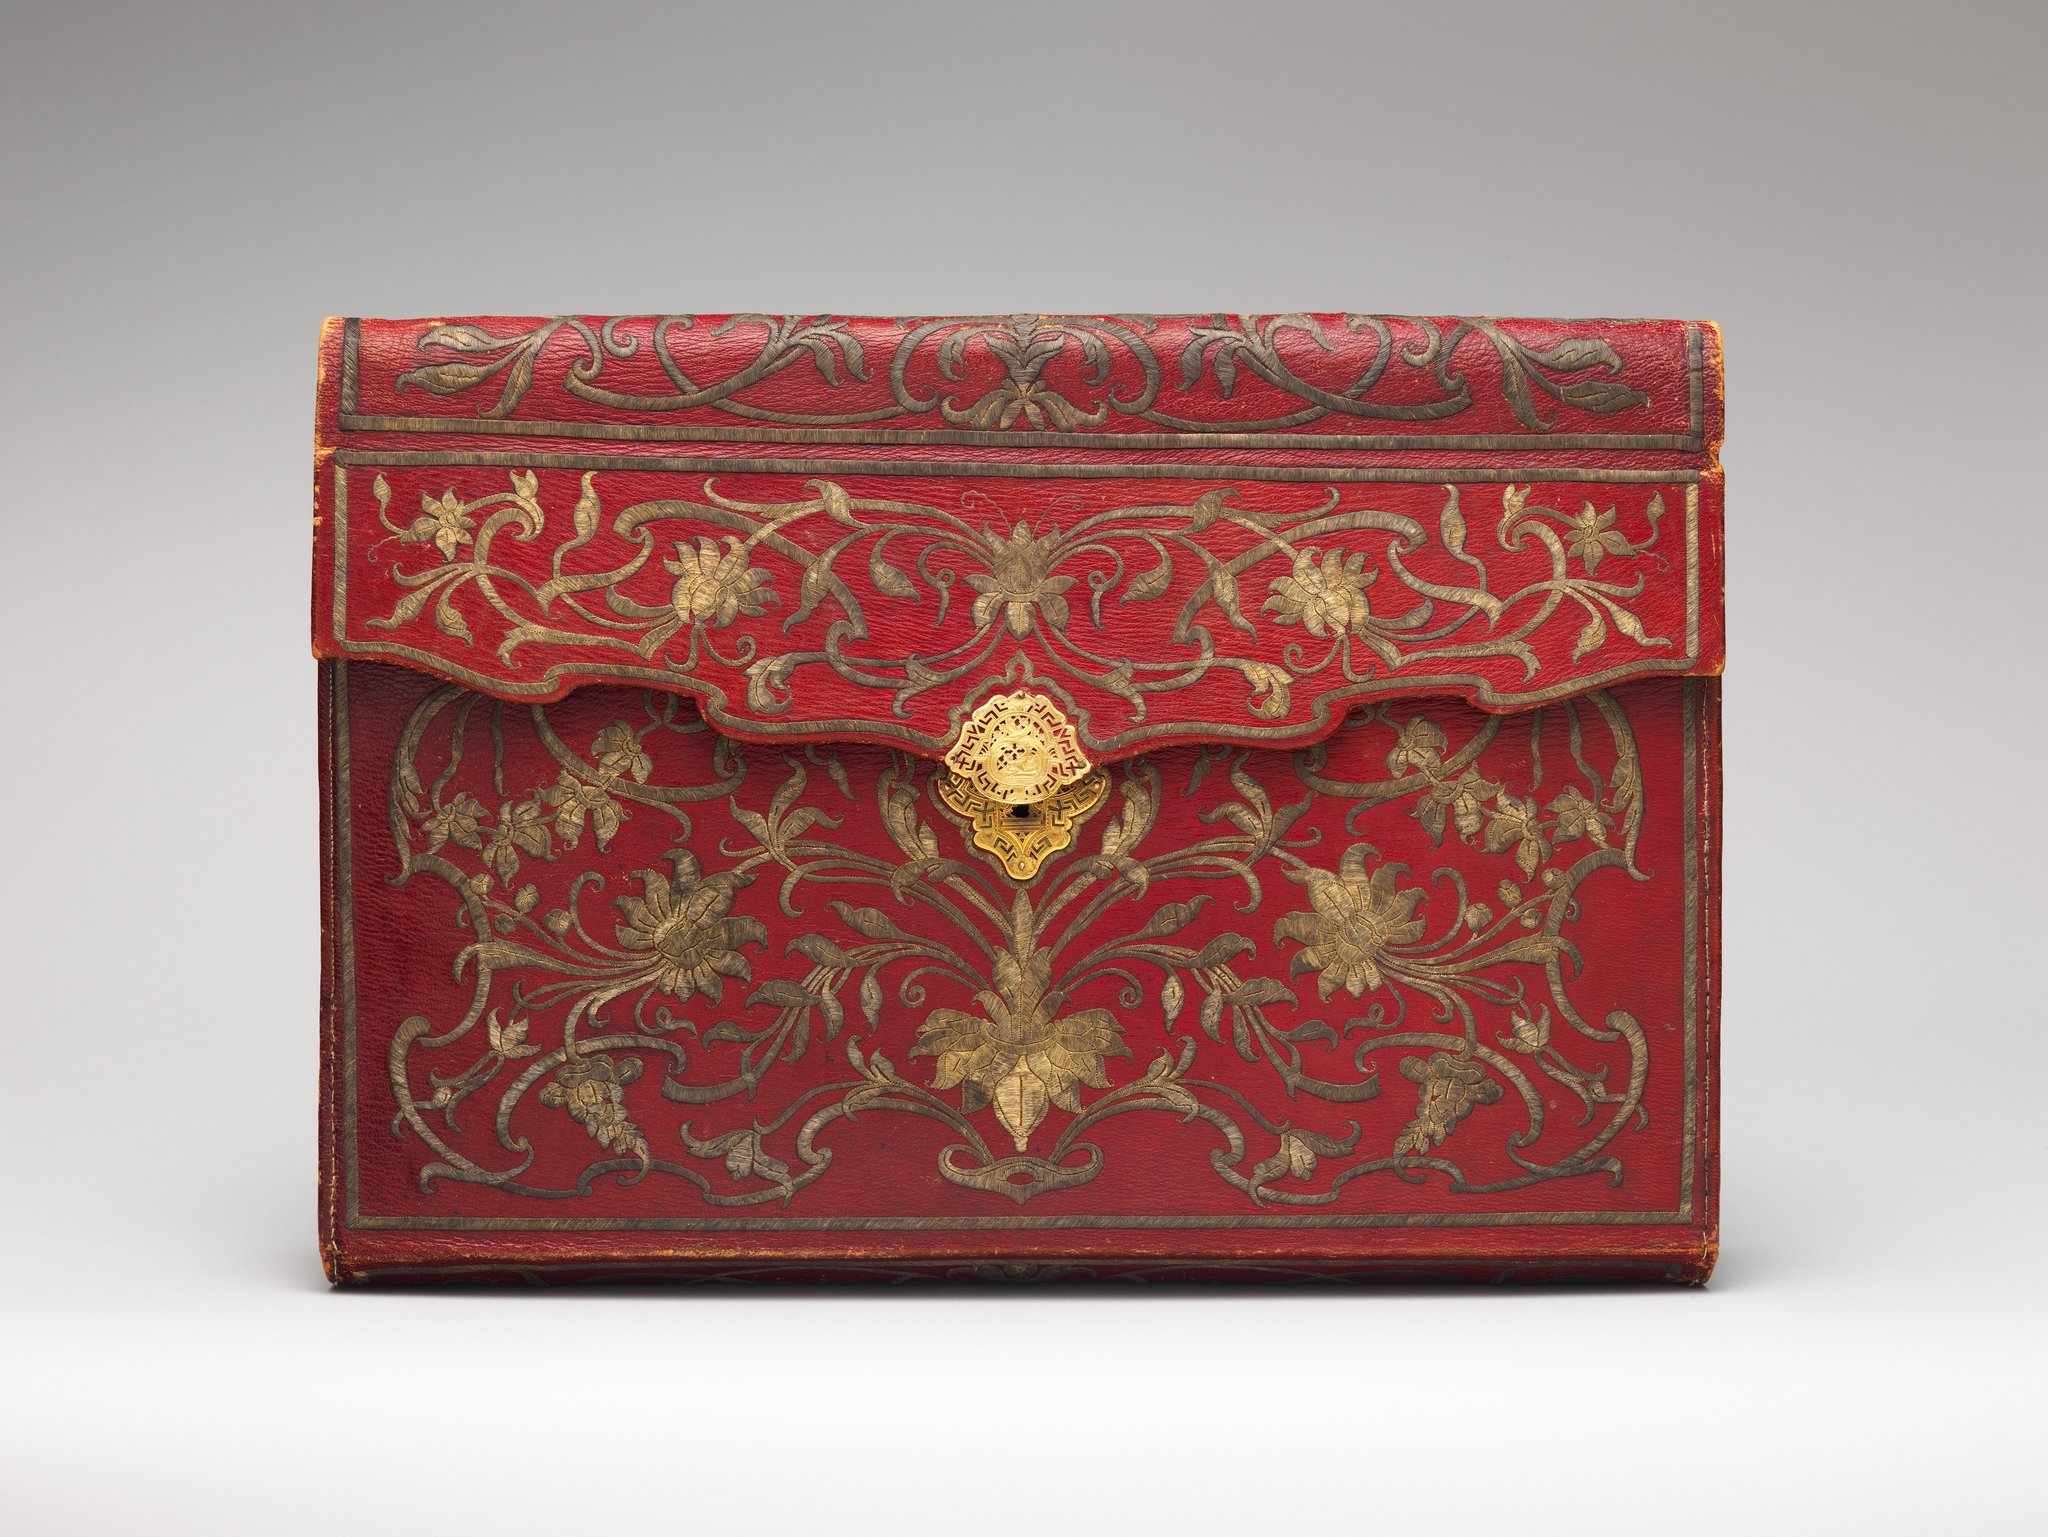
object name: briefcase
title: Briefcase (portefeuille)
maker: jacques lourdière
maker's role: lock maker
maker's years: 1716-1798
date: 1763-1764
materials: gold, gold thread, leather, silk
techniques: embroidery